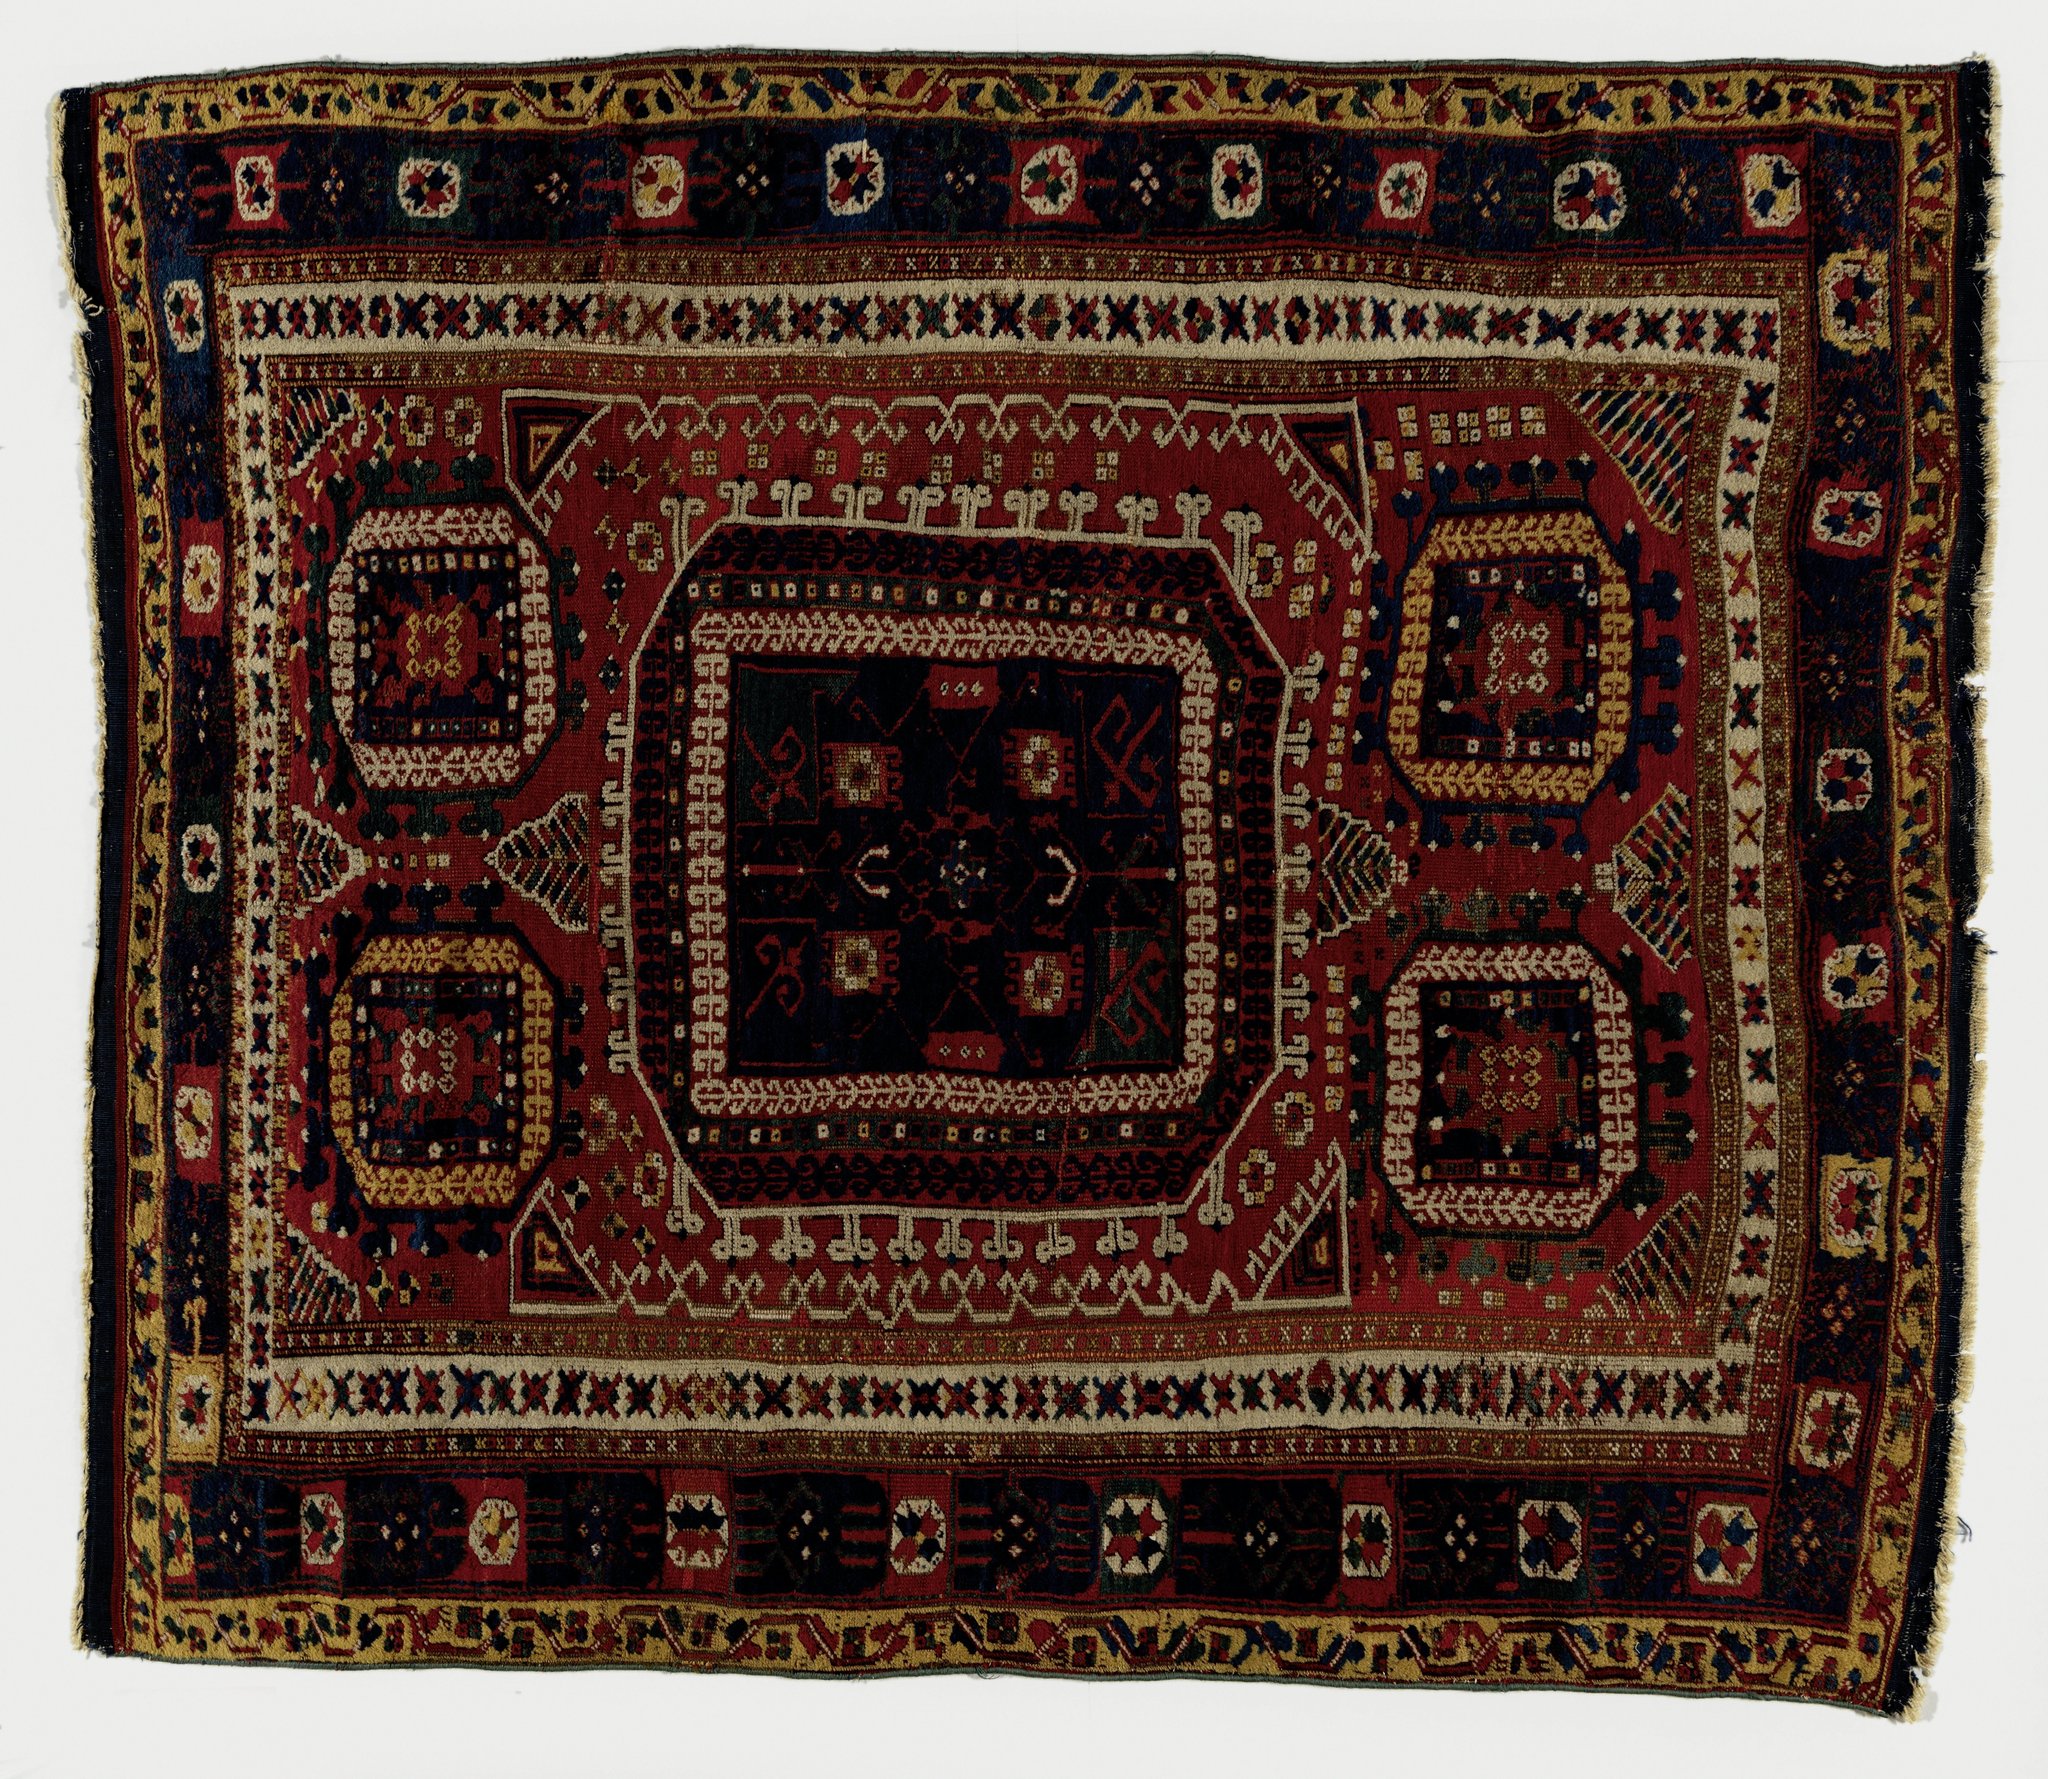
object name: oriental rug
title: Oosters tapijt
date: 1700-1900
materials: wool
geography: bergama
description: Oosters tapijt, Holbeintapijt. In het middenveld een groot medaillon. Hieronder en hierboven twee kleinere medaillons. Dubbele rand, de binnenste met geometrische ornamenten, de buitenste met geometrische ranken. Knoop: Ghiordes knoop.